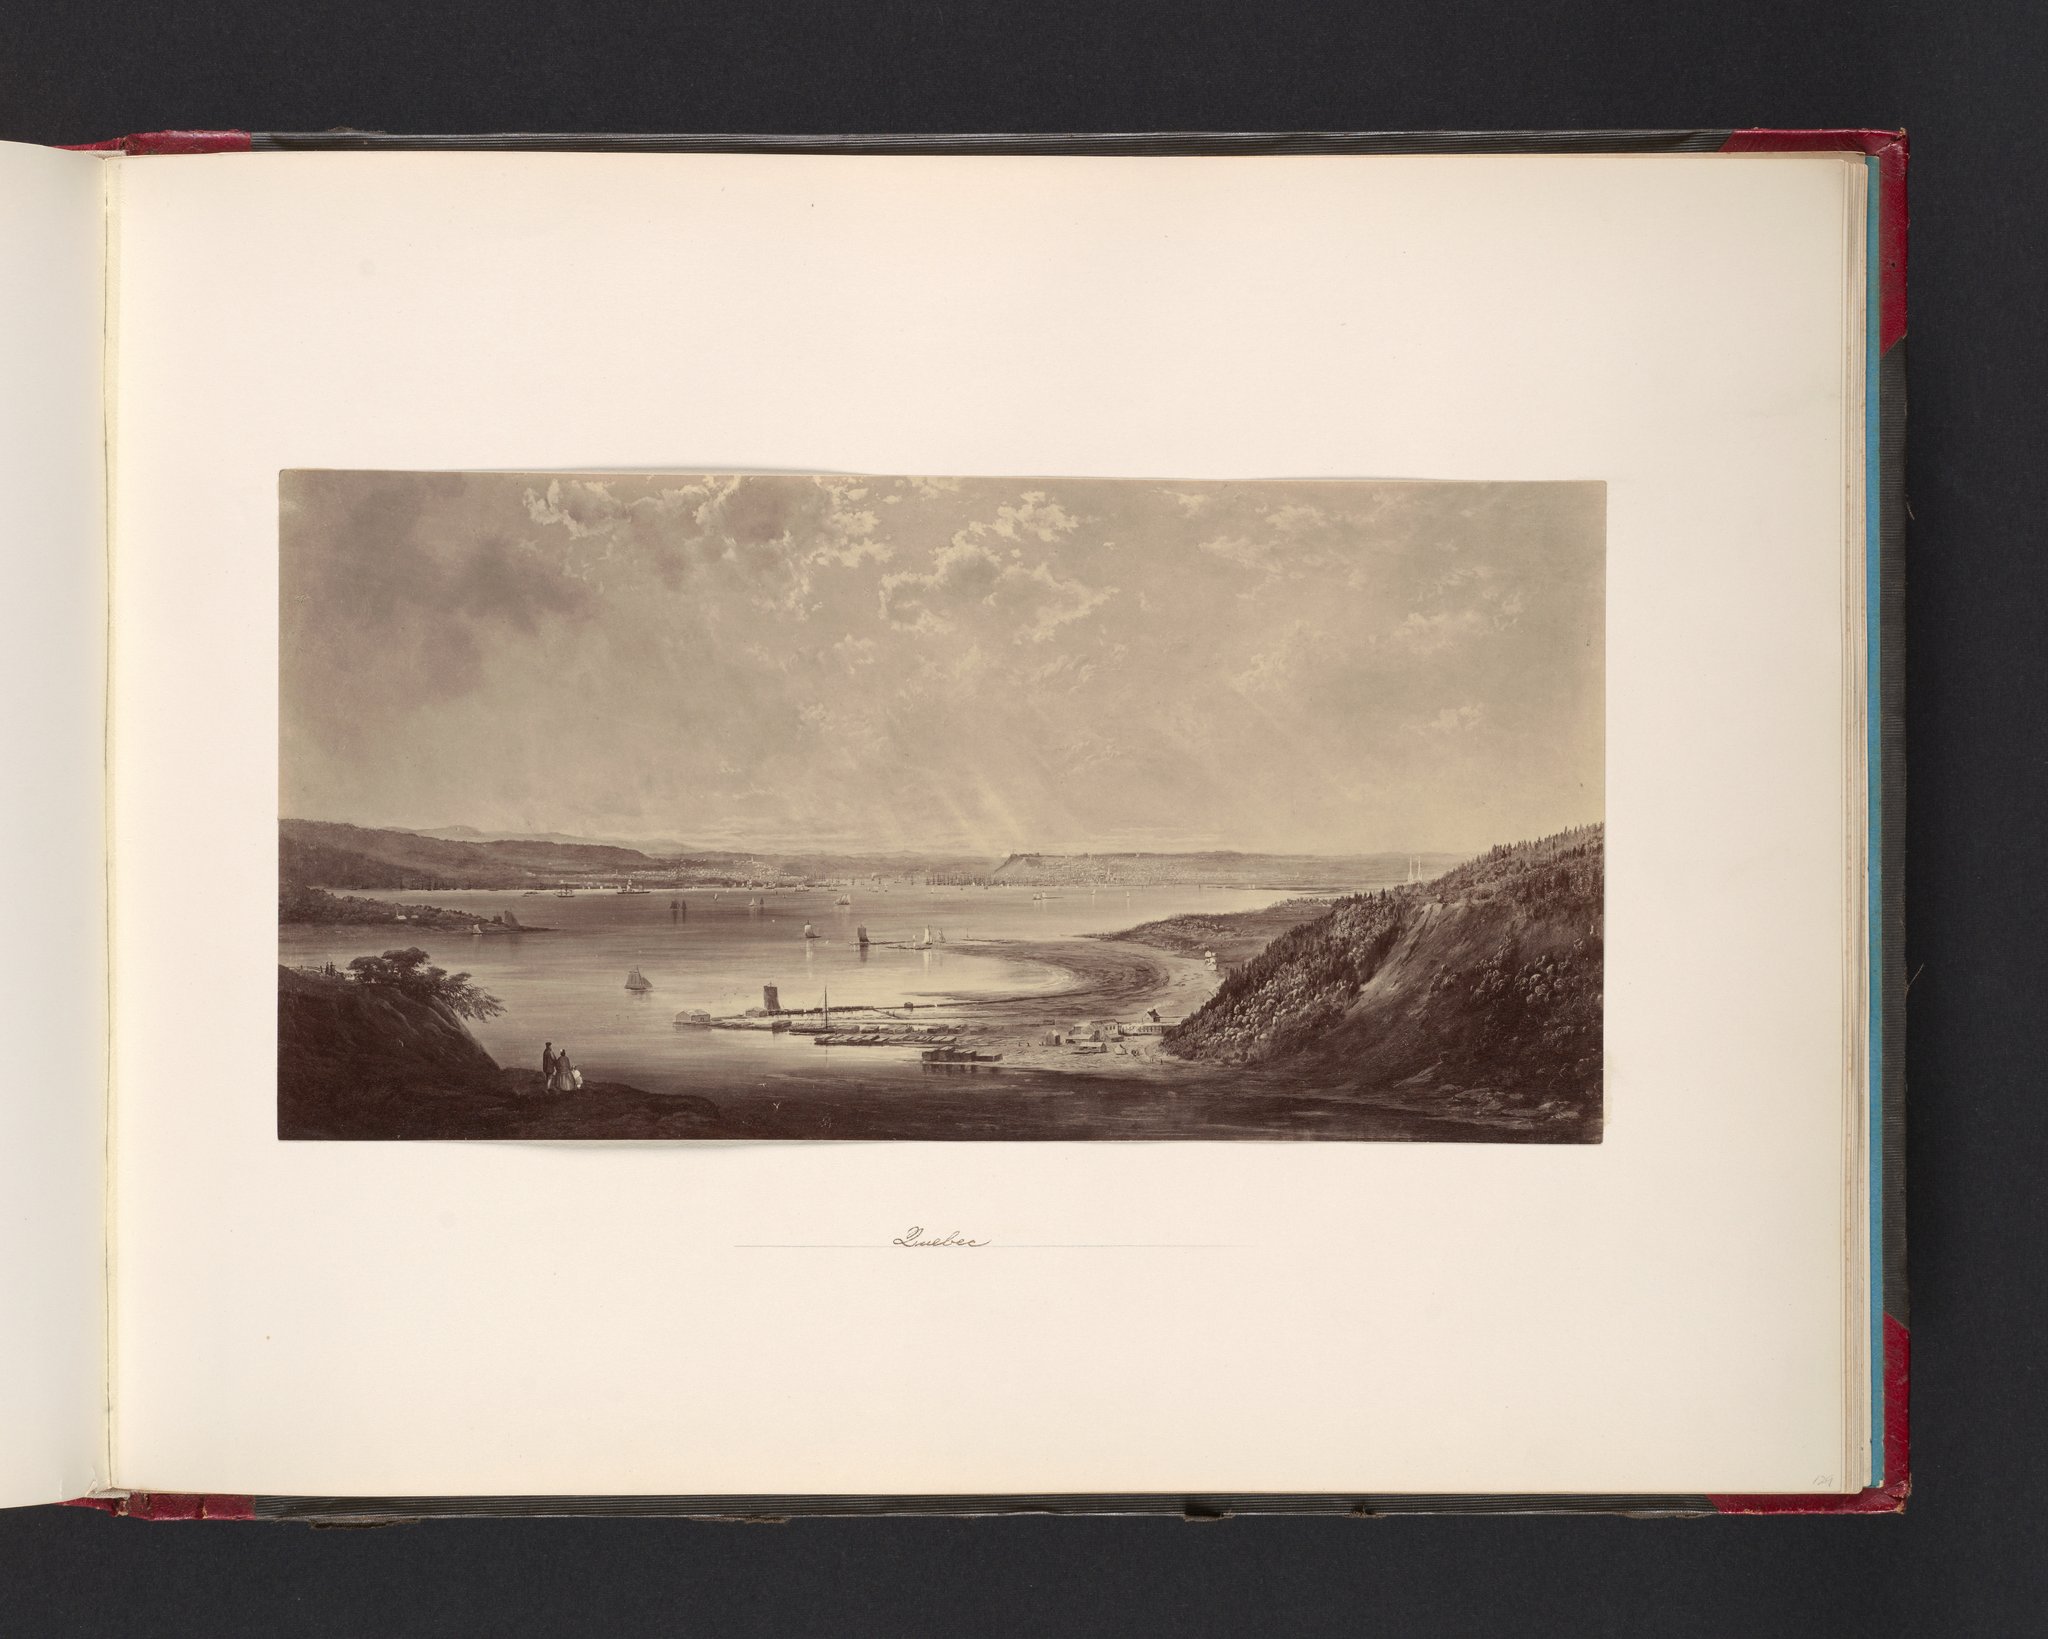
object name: photograph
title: Quebec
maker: john thomson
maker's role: artist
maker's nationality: british, scottish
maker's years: 1837-1921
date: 1865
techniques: albumen silver print, glass negative